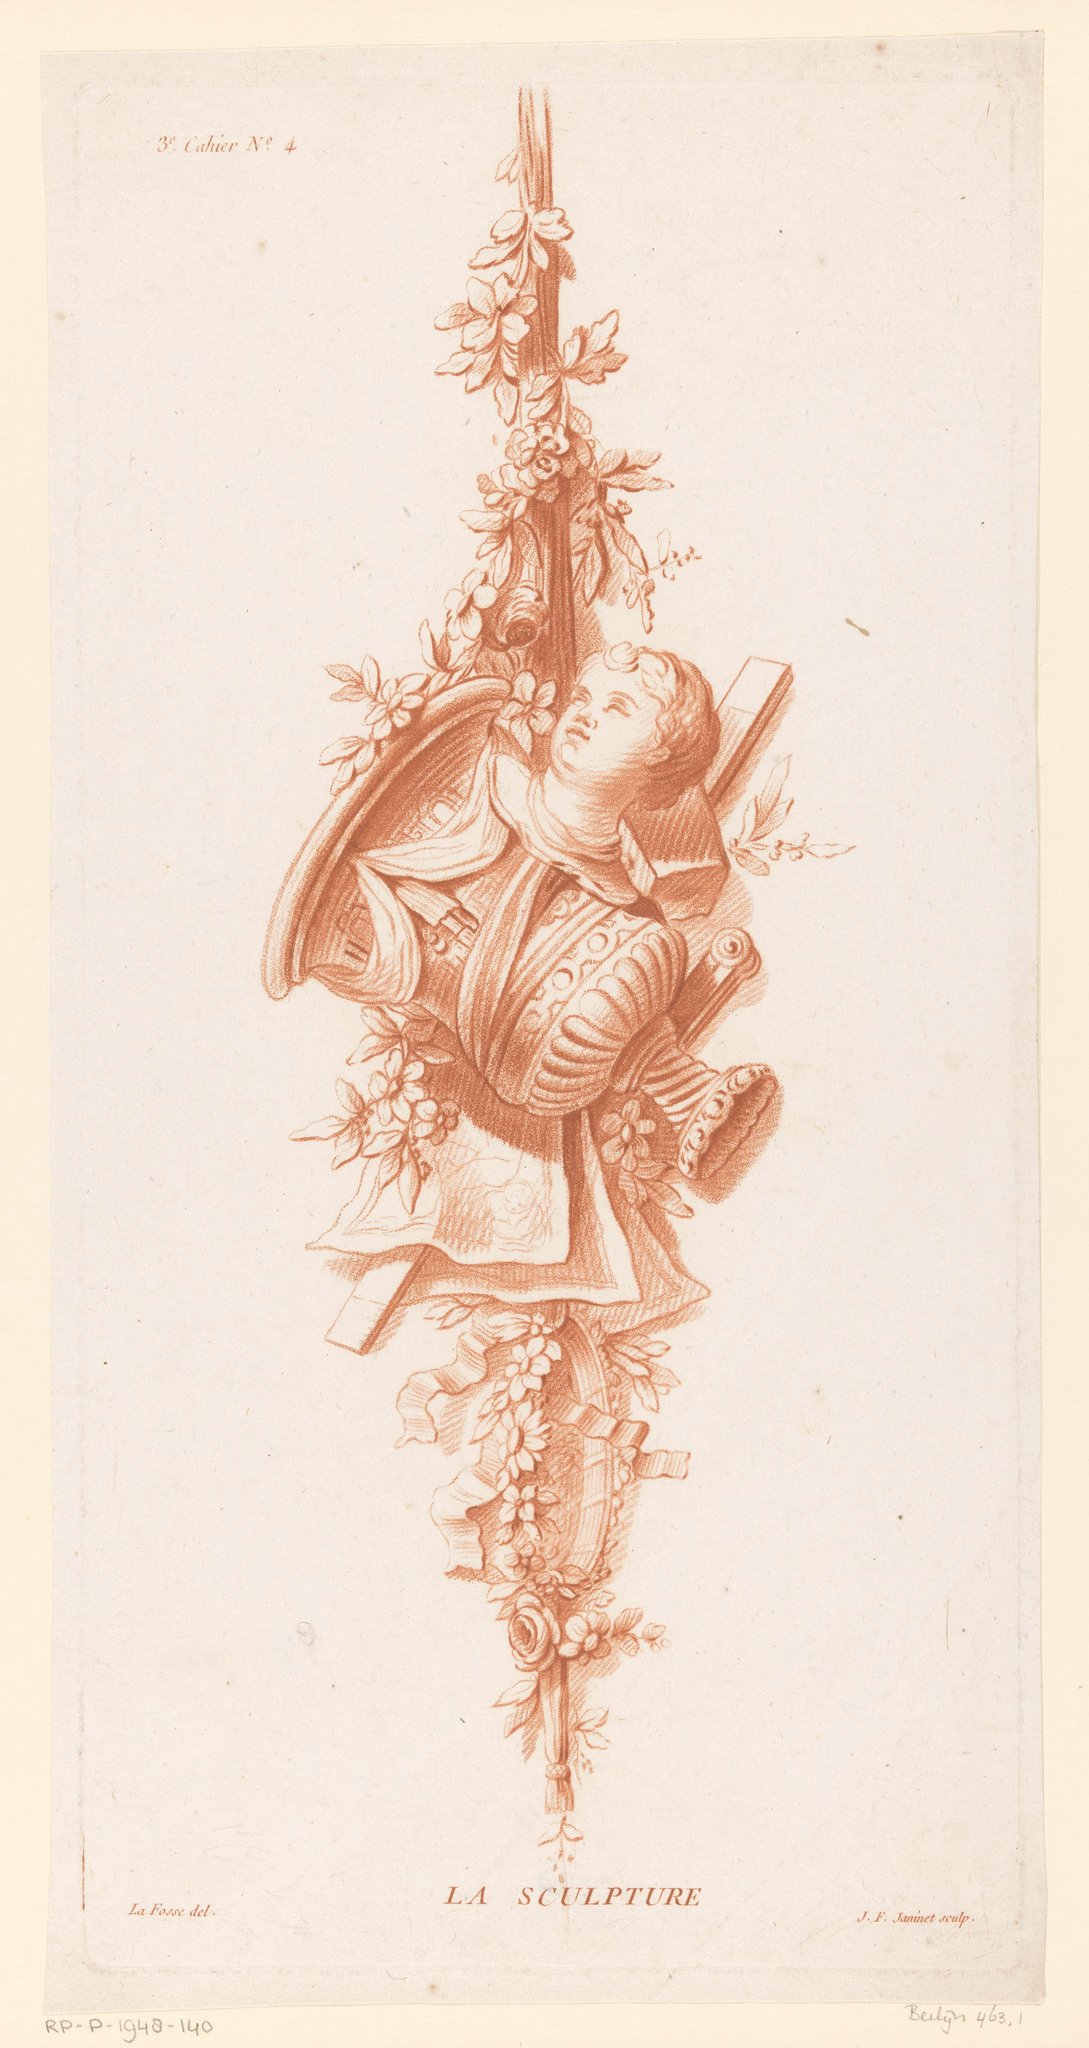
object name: print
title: La Sculpture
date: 1772-1779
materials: paper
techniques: printmaking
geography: paris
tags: trophy, i.e.: decorative arrangement of symbolic or typical objects ~ ornament, sculpture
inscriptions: collector's mark: Lugt 2228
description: Een trofee met attributen behorende bij beeldhouwkunst zoals een buste, een vaas, schetsen en meetinstrumenten.